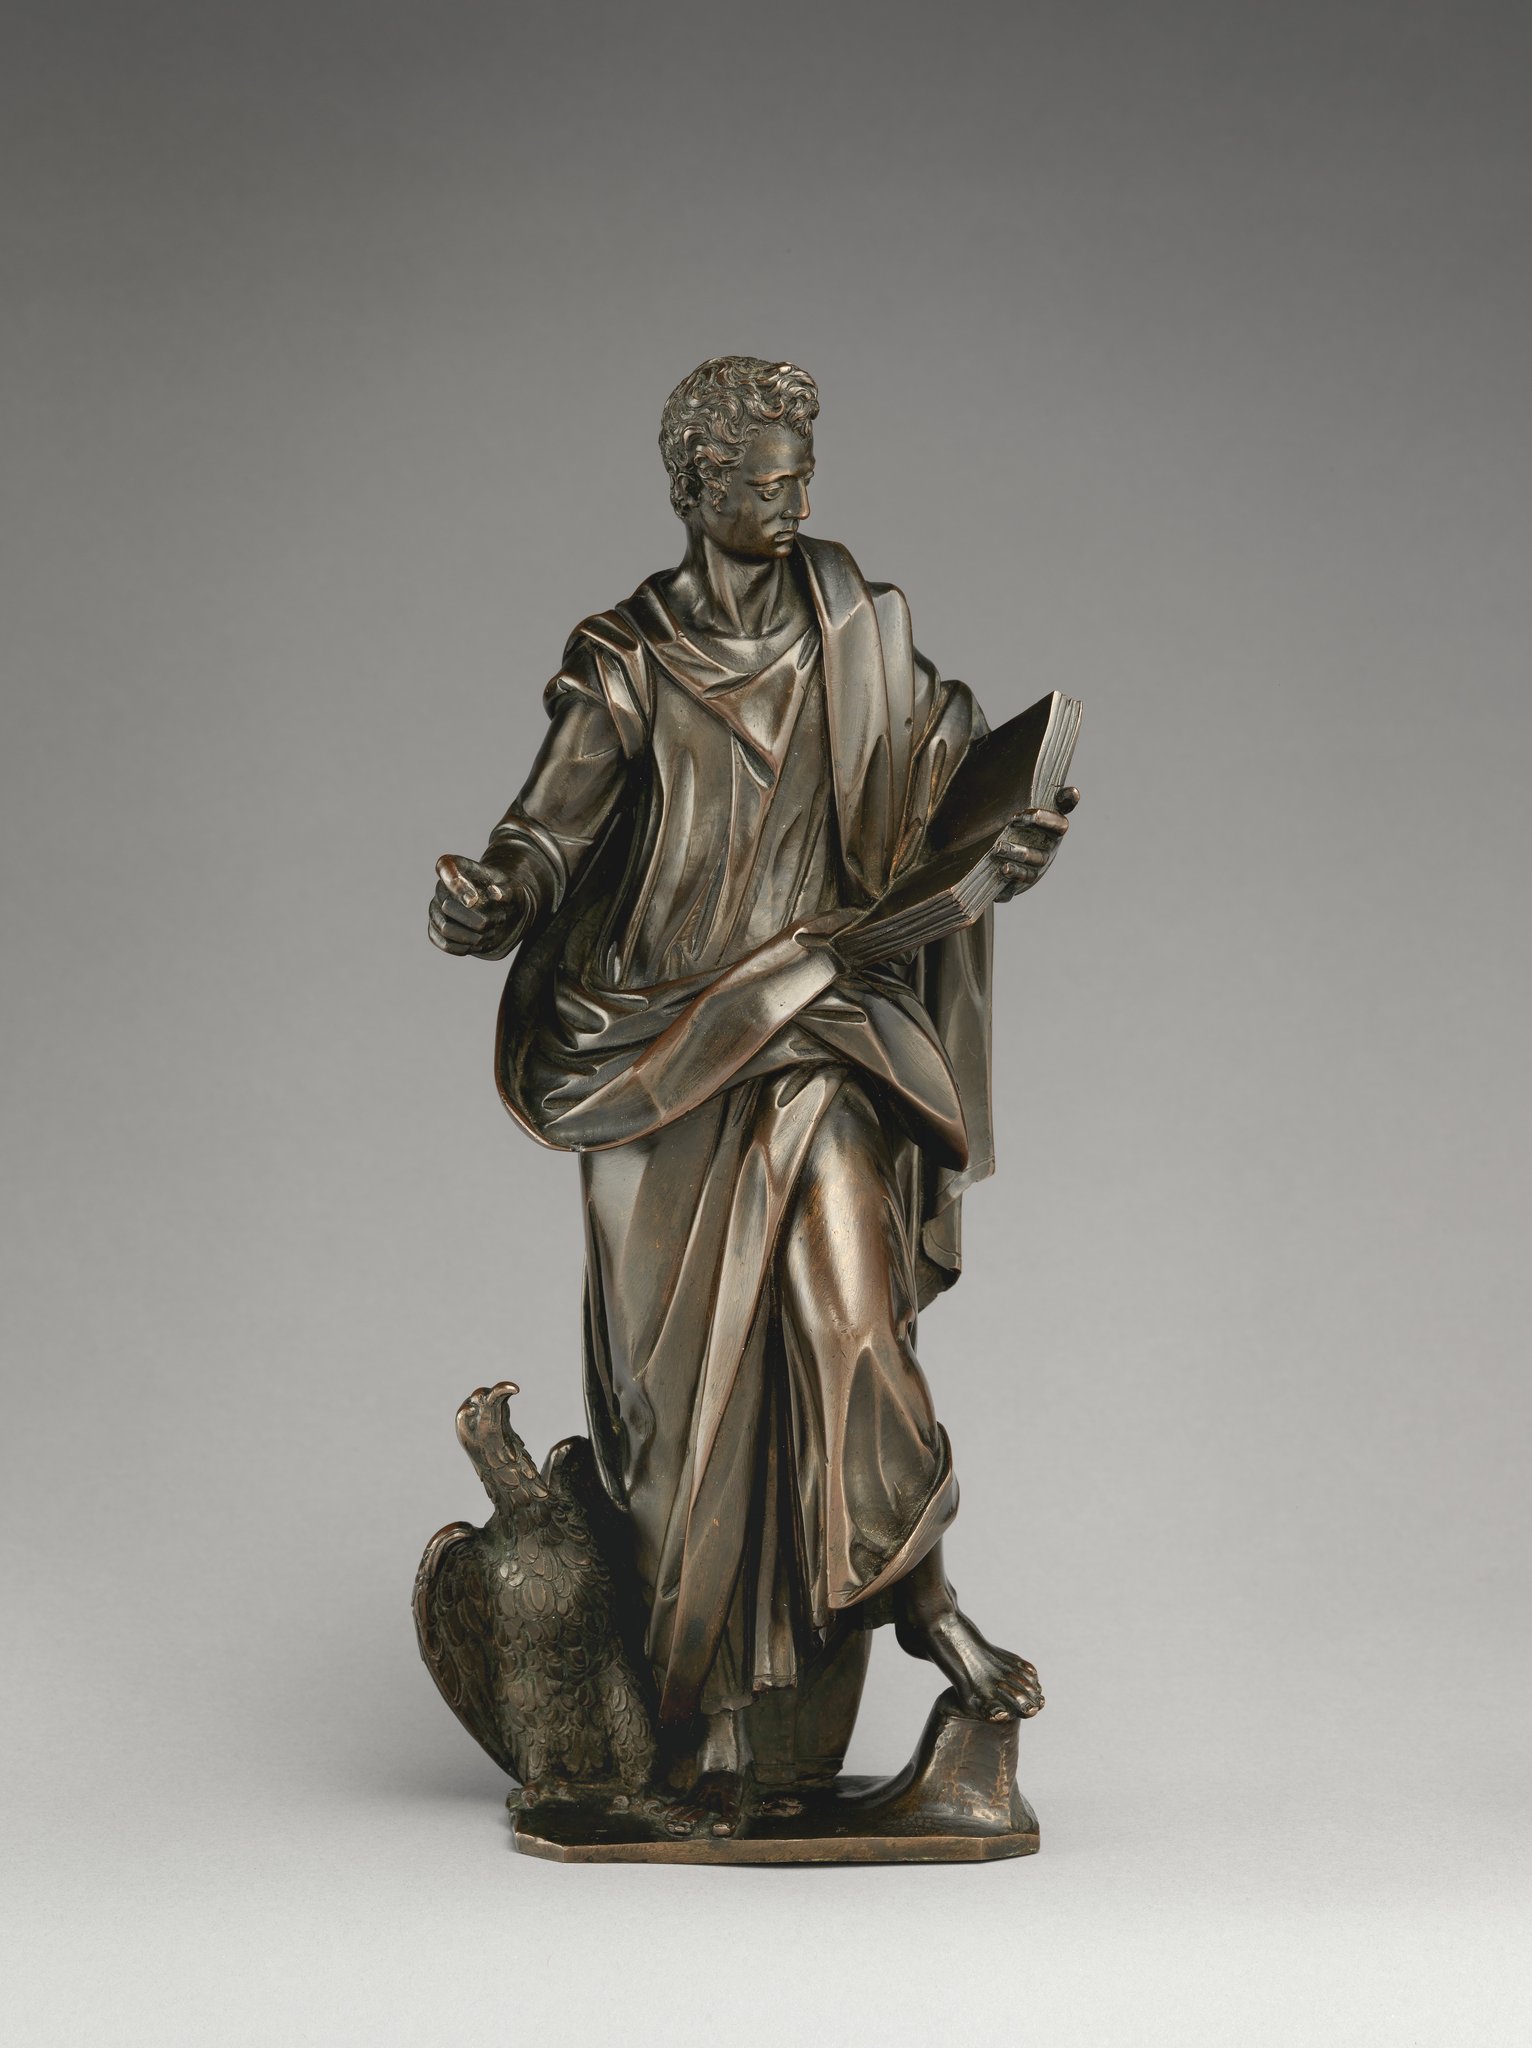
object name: statuette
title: Saint John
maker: antonio susini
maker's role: artist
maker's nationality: italian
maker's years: 1558-1624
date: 1596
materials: bronze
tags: eagles,saint john the evangelist